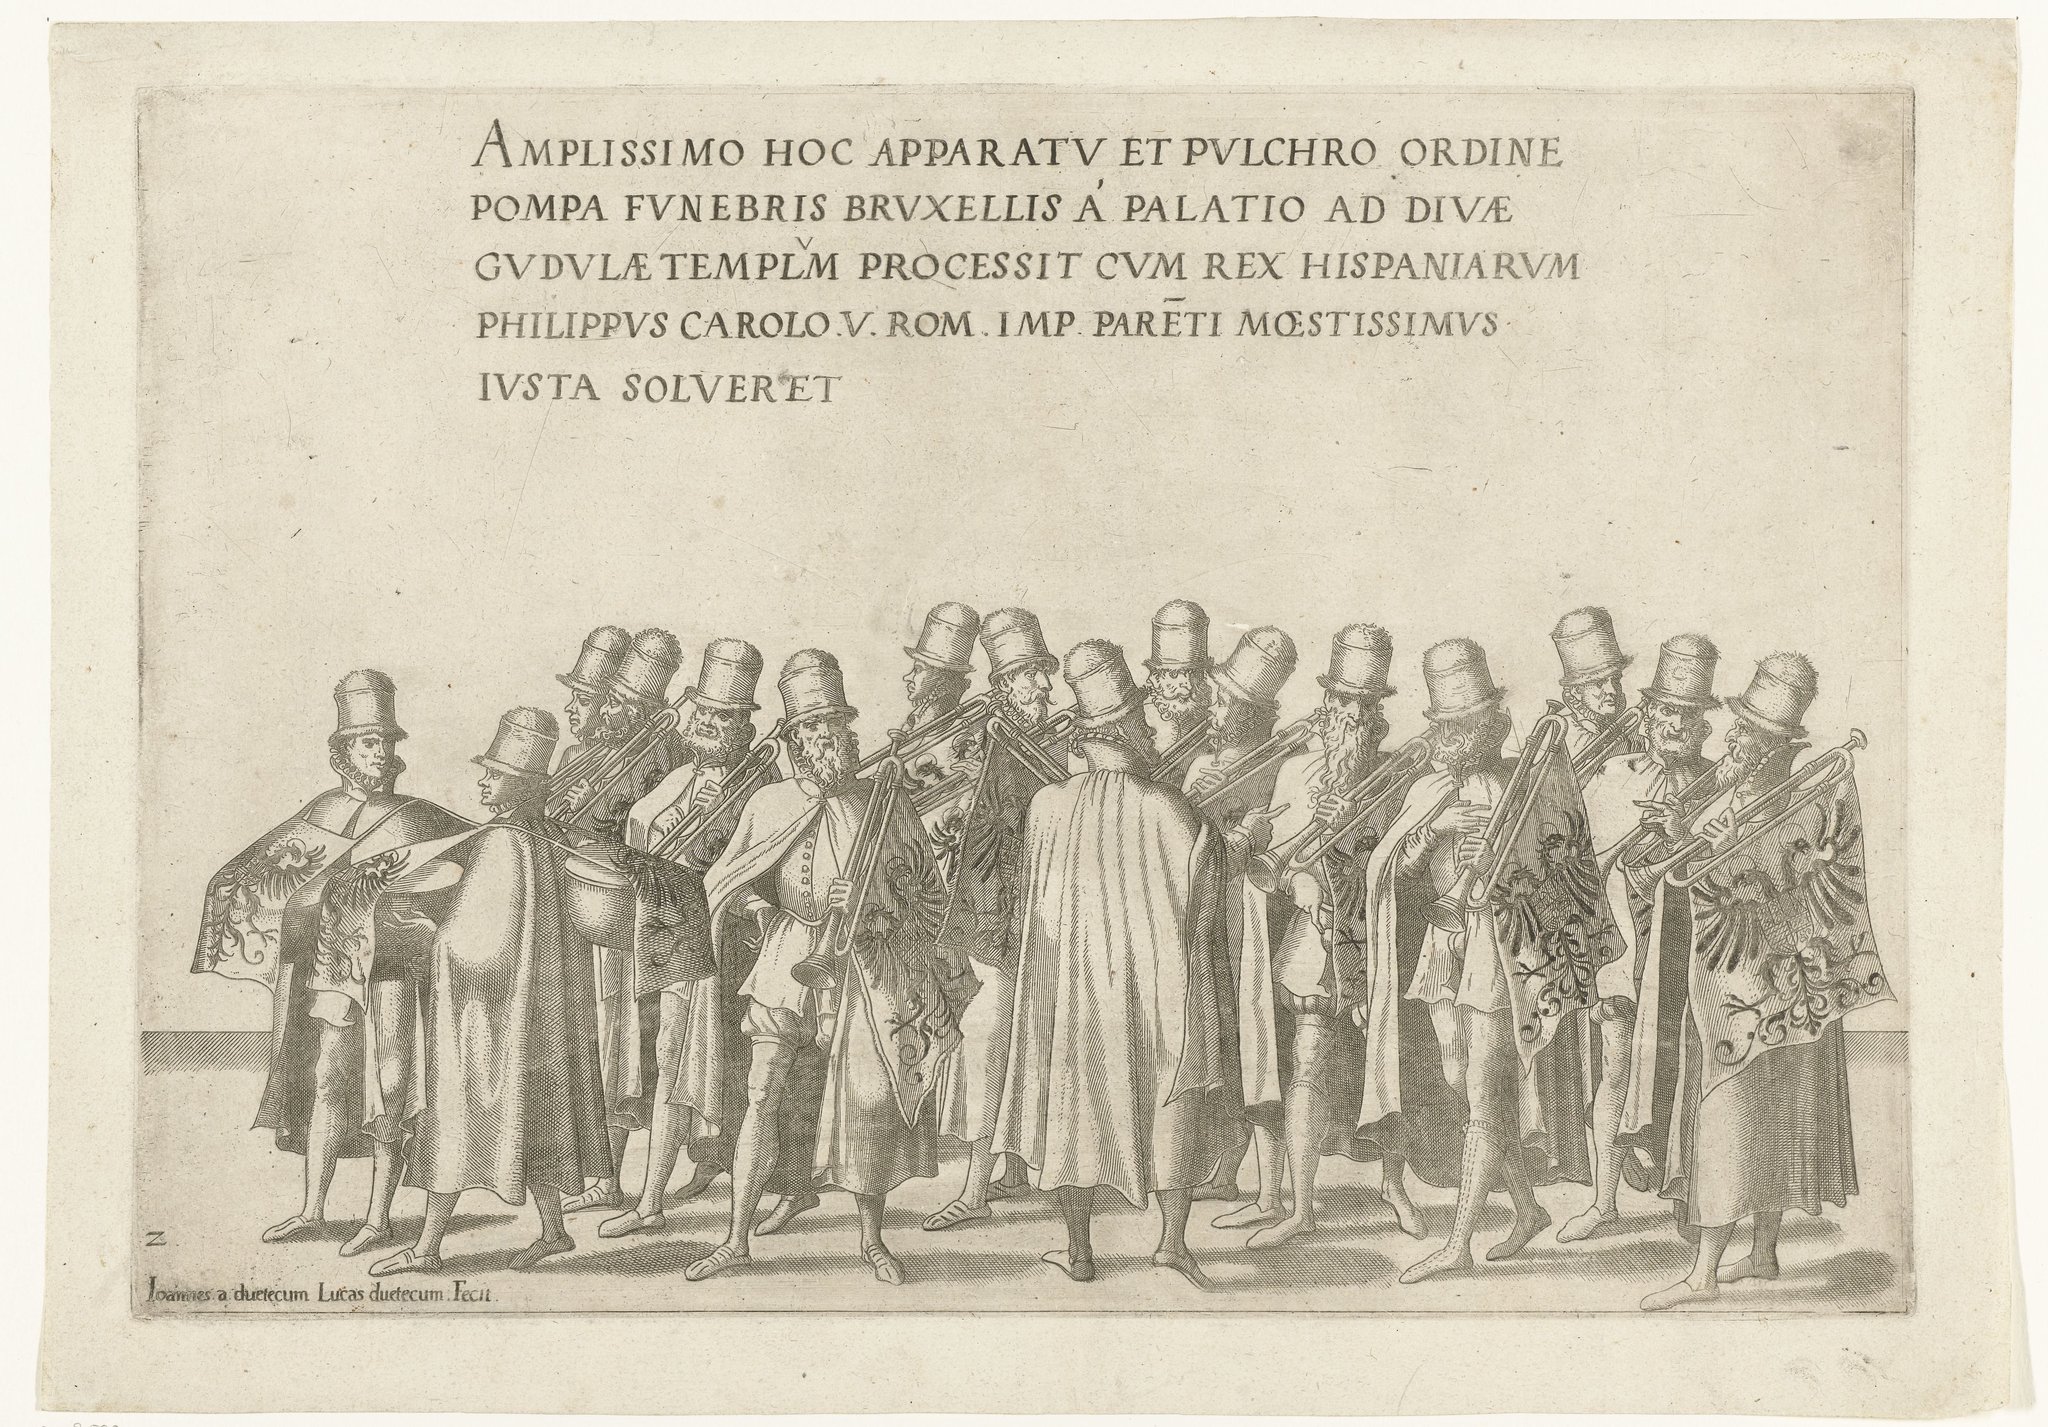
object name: print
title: Begrafenisoptocht van keizer Karel V, 1558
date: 1559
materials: paper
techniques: engraving, etching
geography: southern netherlands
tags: charles v (holy roman emperor and king of spain), cortege, funeral procession, brussels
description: Groep muzikanten met trompetten met vaandels en twee trommelaars. Onderdeel van de prentreeks van de Begrafenisoptocht van keizer Karel V op 29 december 1558 te Brussel.